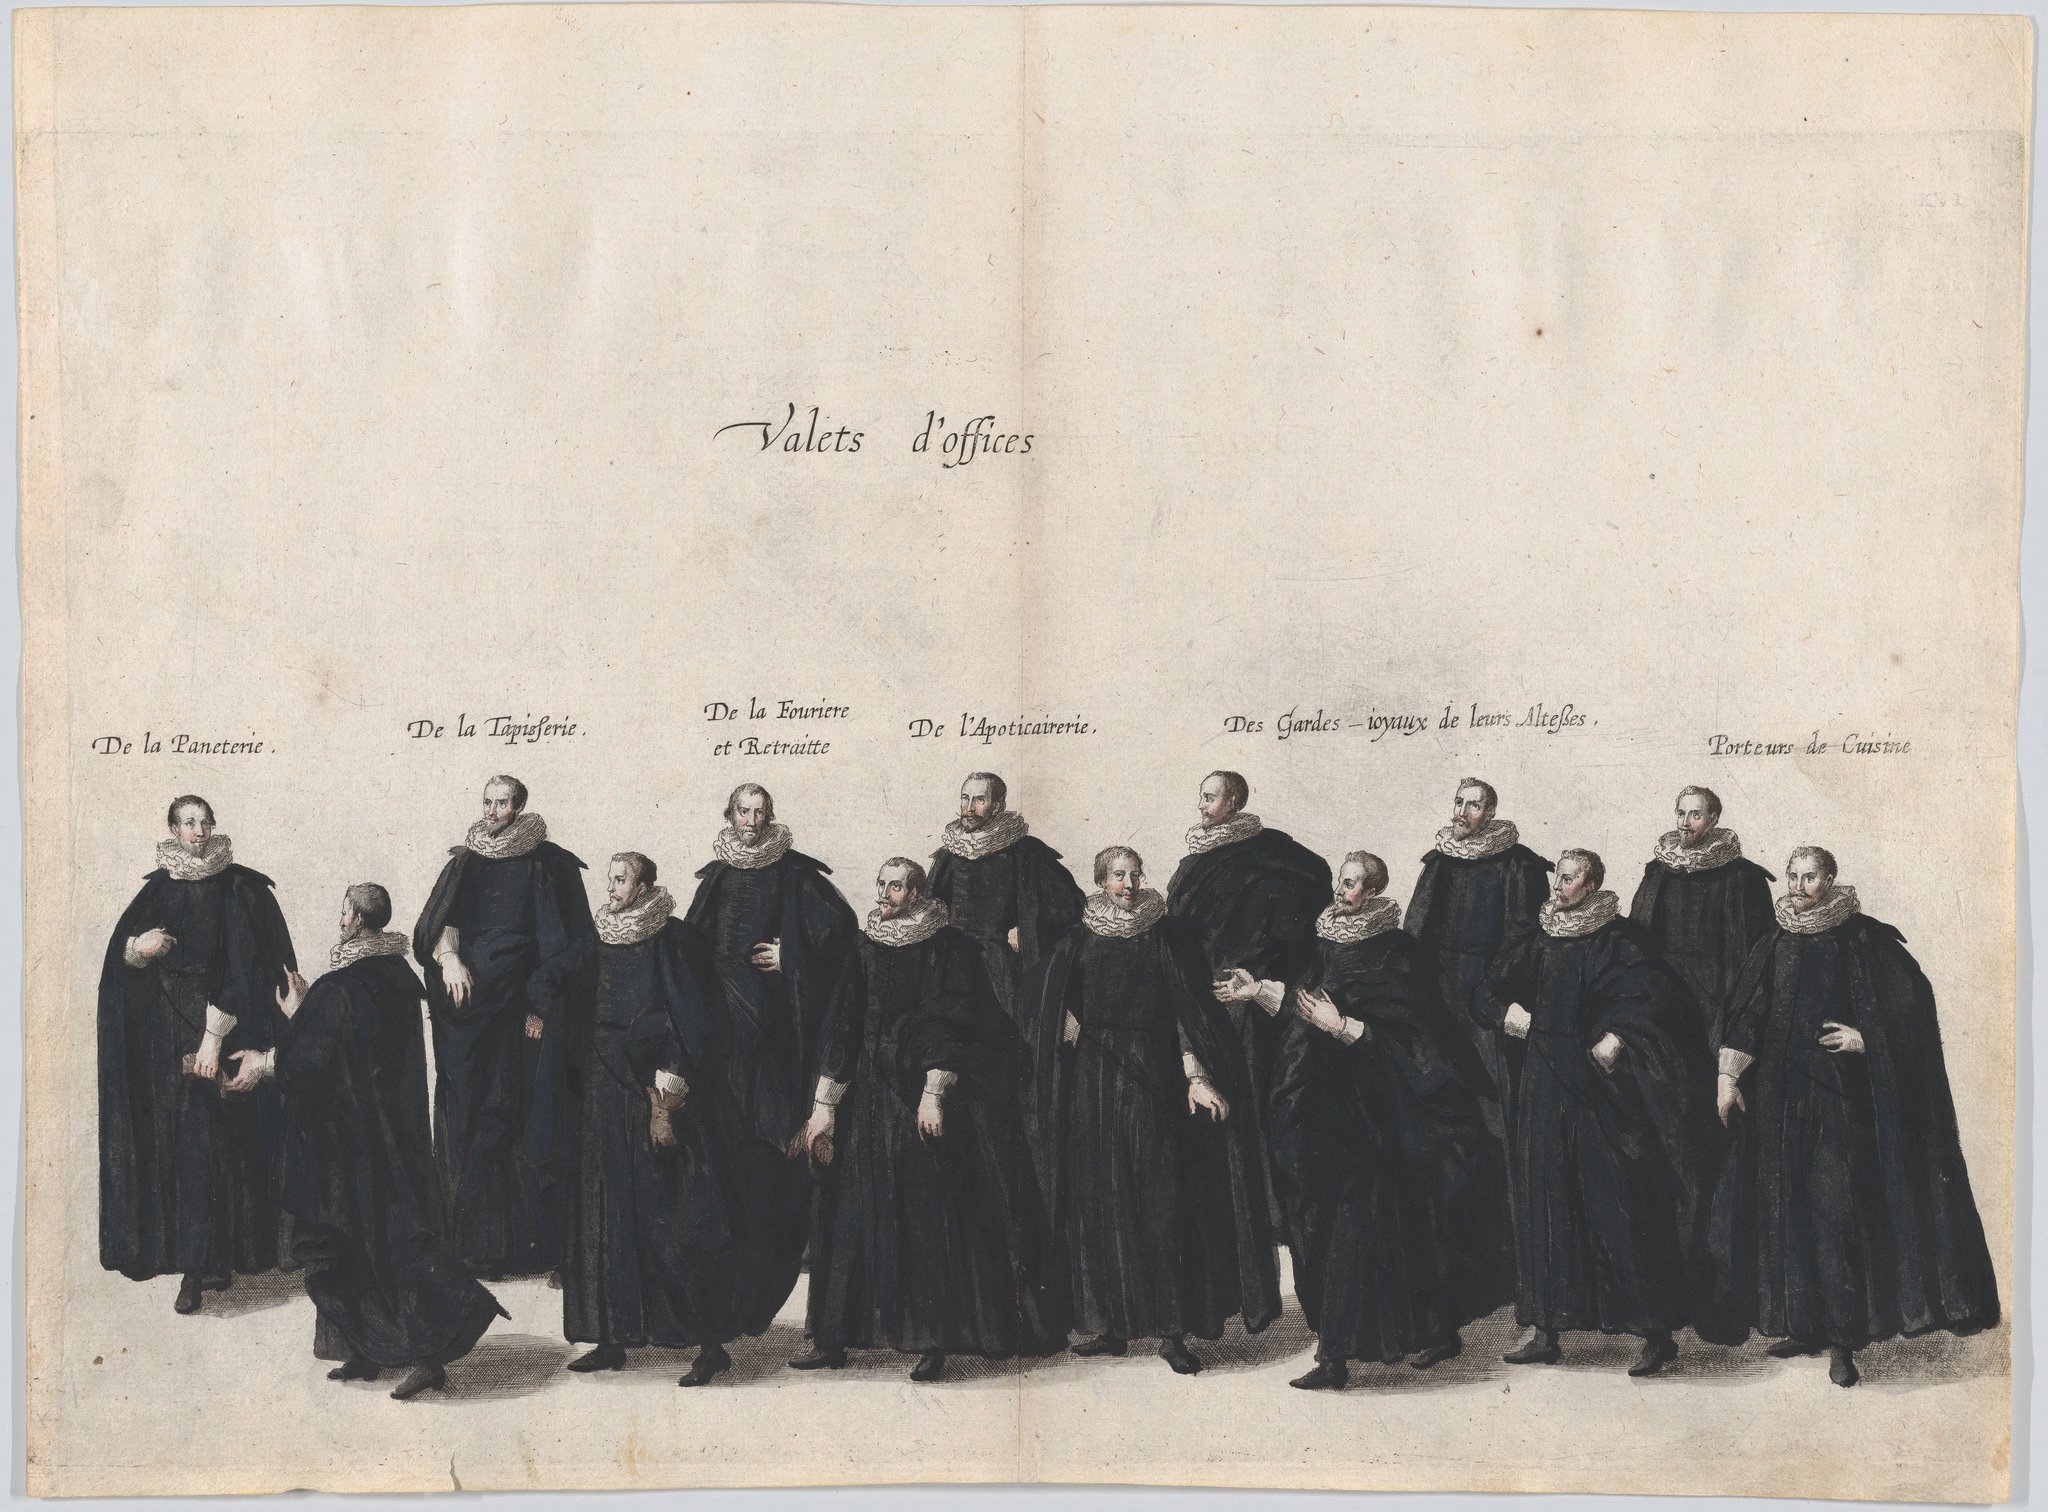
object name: print, fete, ornament architecture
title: Plate 16: Valets marching in the funeral procession of Archduke Albert of Austria; from 'Pompa Funebris ... Alberti Pii'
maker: cornelis galle (i)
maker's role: artist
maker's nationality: netherlandish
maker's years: 1576-1650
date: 1623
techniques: etching, hand coloring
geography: brussels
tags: men,funerals